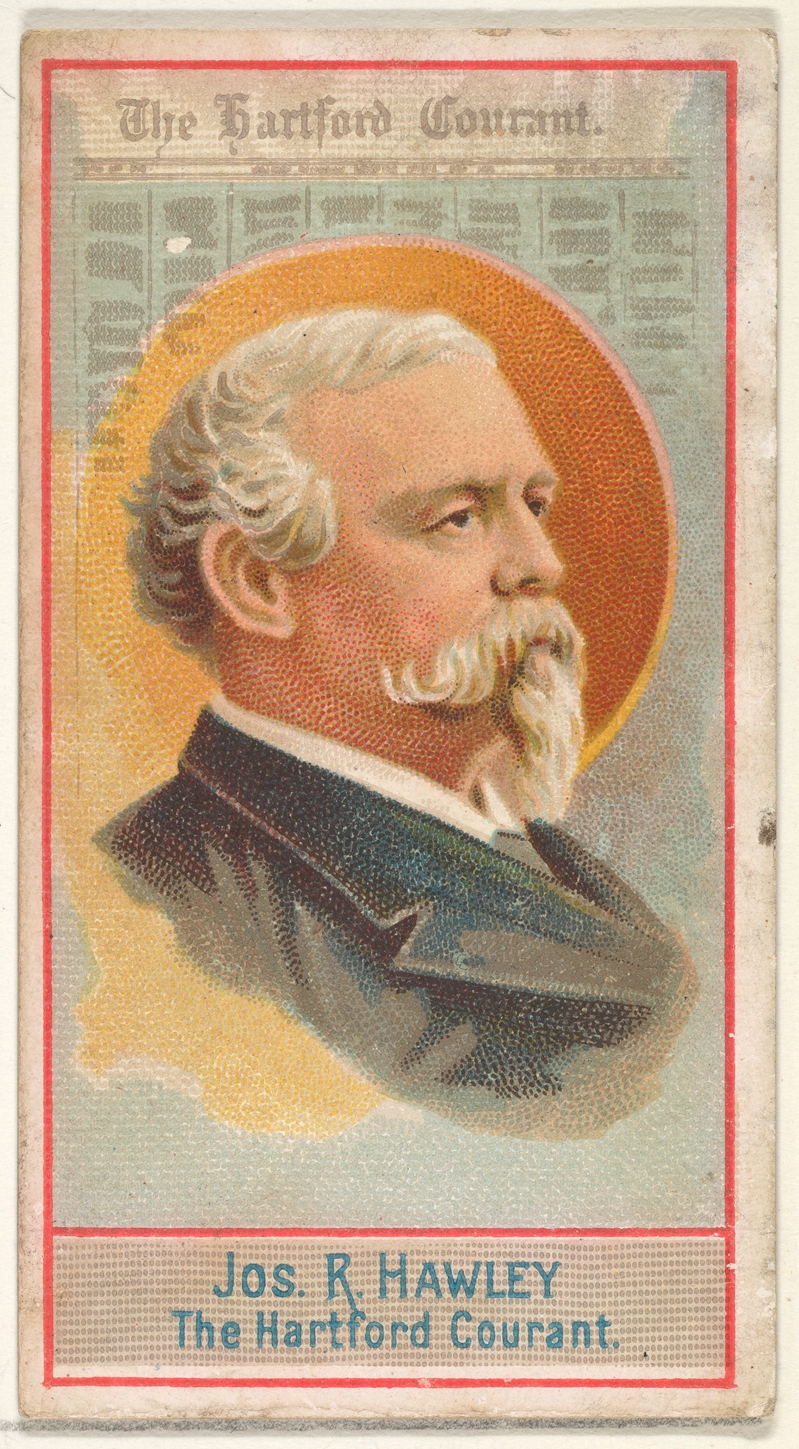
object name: print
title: Joseph R. Hawley, The Hartford Courant, from the American Editors series (N1) for Allen & Ginter Cigarettes Brands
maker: allen & ginter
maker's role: publisher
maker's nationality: american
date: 1887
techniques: color lithograph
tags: men